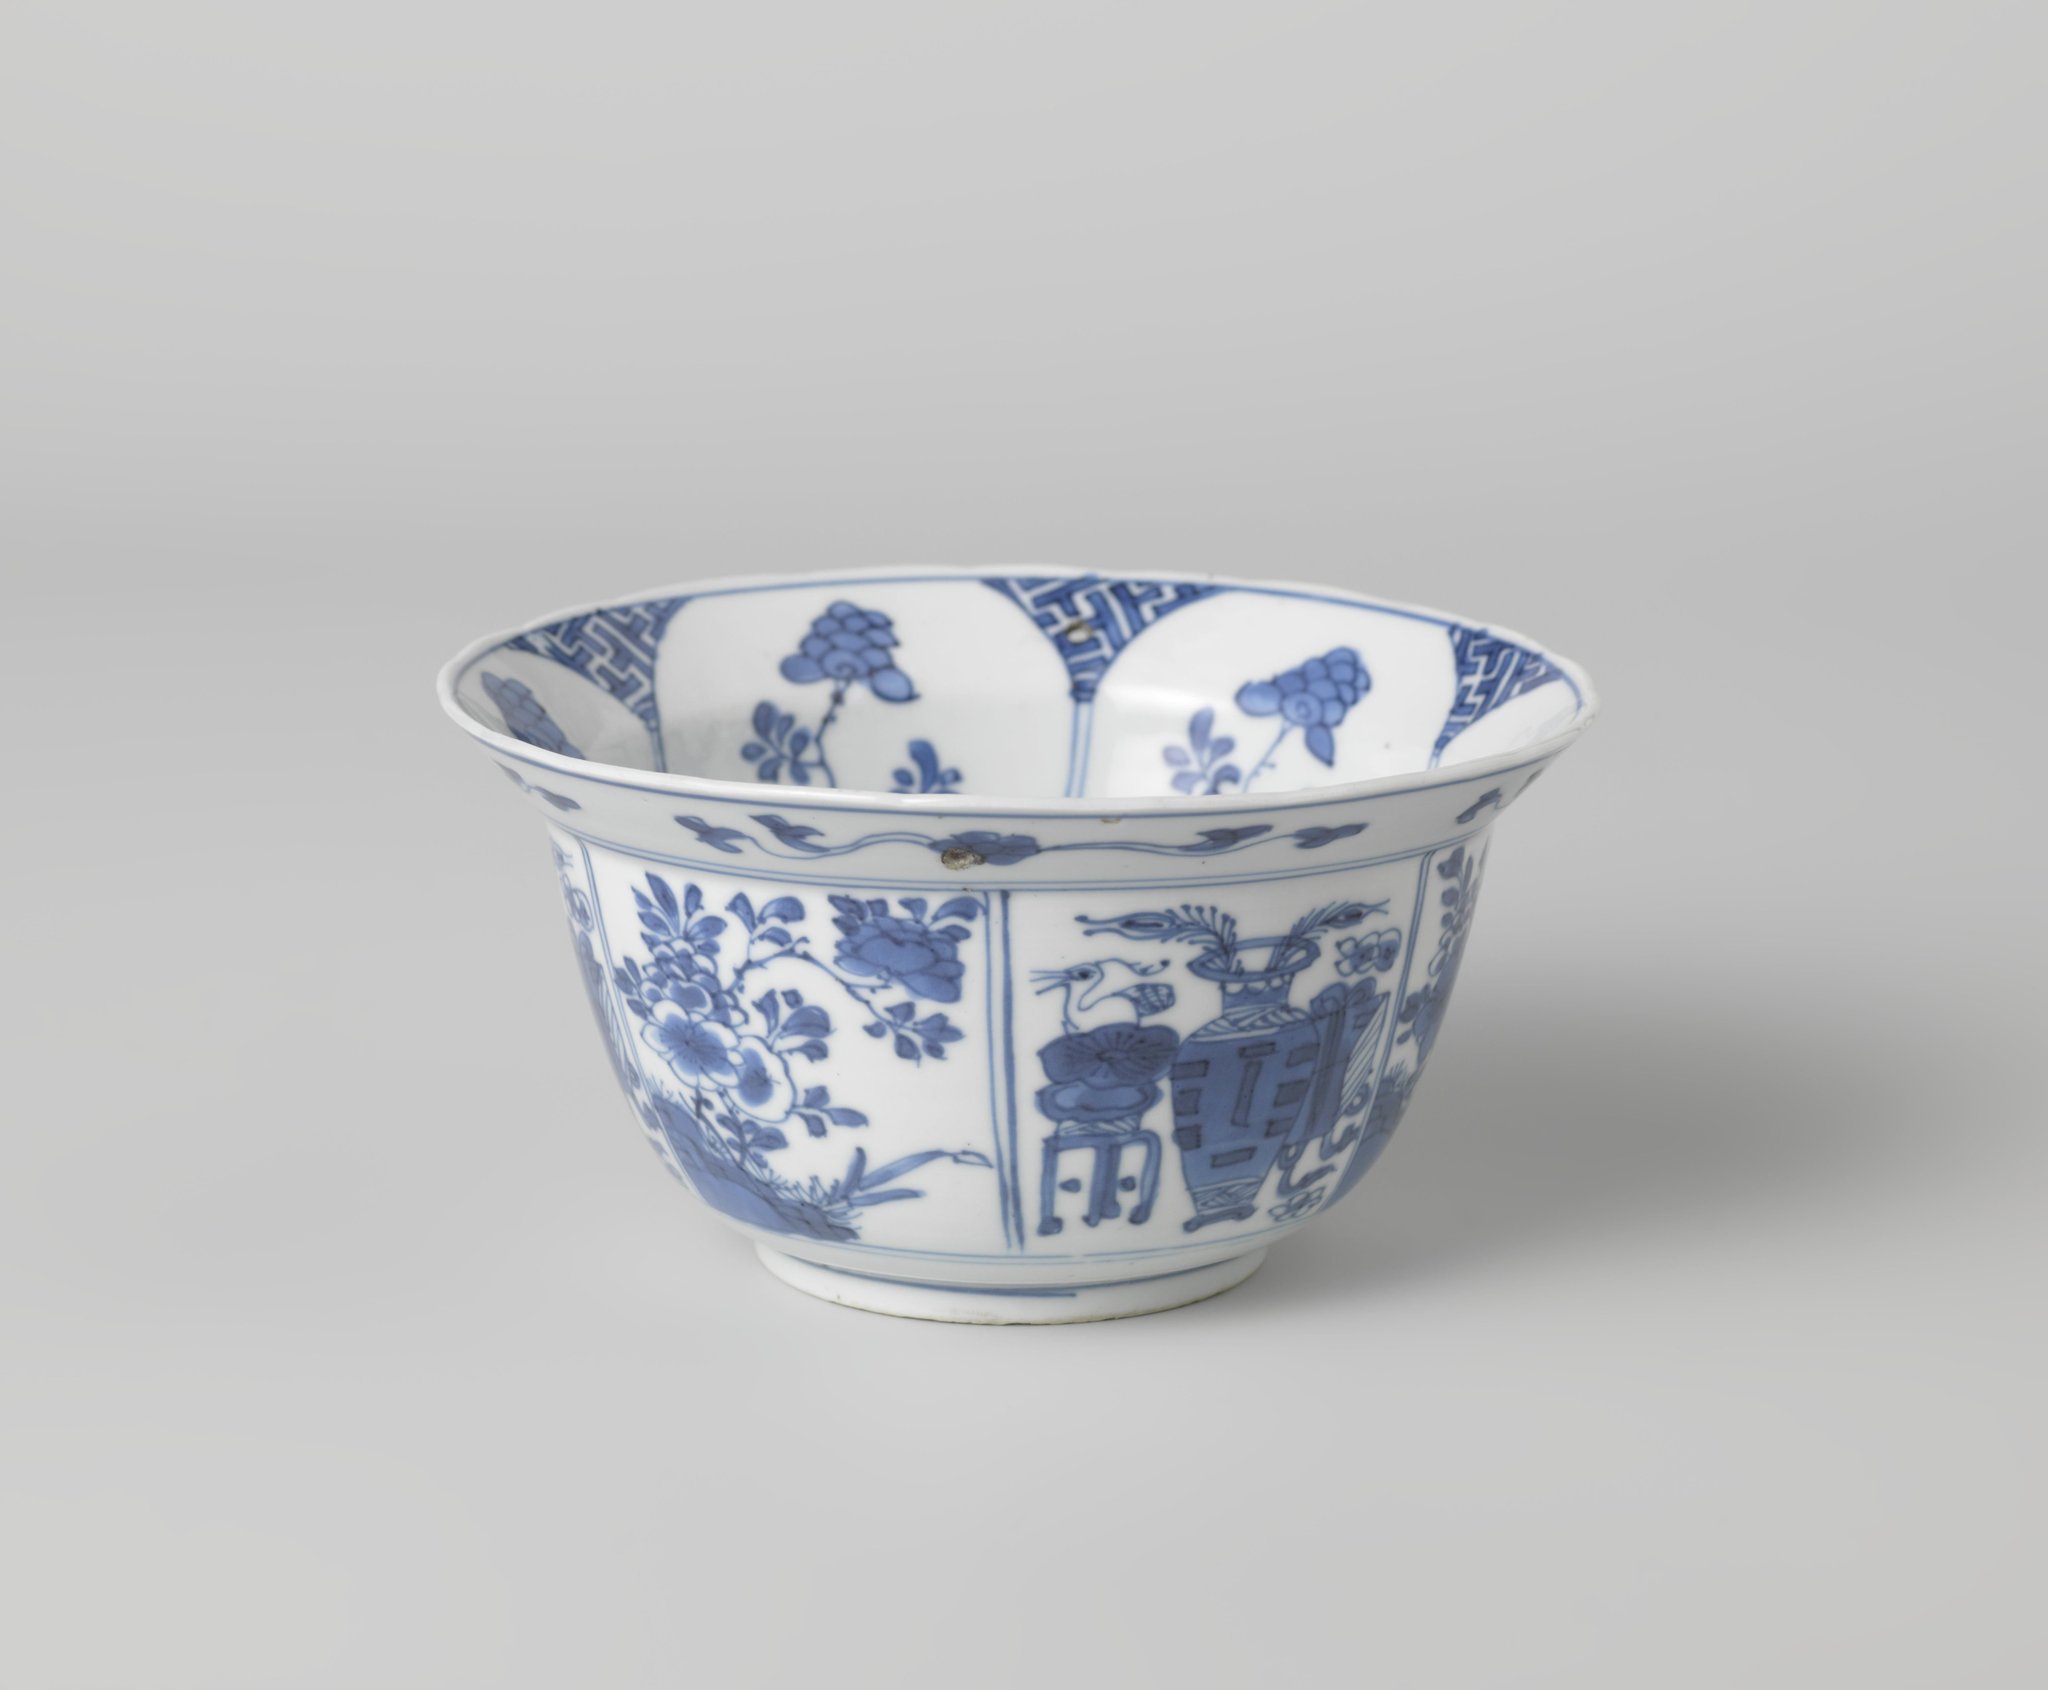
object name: klapmuts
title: Bowl (klapmuts) with flowering plants and auspicious objects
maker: Anonymous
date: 1700-1724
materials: cobalt, glaze, paint, porcelain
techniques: firing, turning, vitrification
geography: china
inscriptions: mark: ‘玉’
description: Kom (klapmuts) van porselein met een geschulpte rand, beschilderd in onderglazuur blauw. De buitenwand is verdeeld in zes vakken, afwisselend gevuld met bloeiende planten bij een rots en kostbaarheden, antiquiteiten en geluksvoorwerpen (artemisiablad, vaas met pauwenveren, rollen, boeken etc.). Op de bodem bloeiende planten bij een rots. De binnenwand is ook verdeeld in zes vakken met in elk een bloemtak; tussen de vakken een swastika-patroon. De buitenrand met viermaal een bloemrank. Gemerkt op de onderzijde met het karakter 'yù' in een dubbele cirkel. Twee geboorde gaten in de rand, waarschijnlijk voor een metalen handvat van later datum. Blauw-wit.